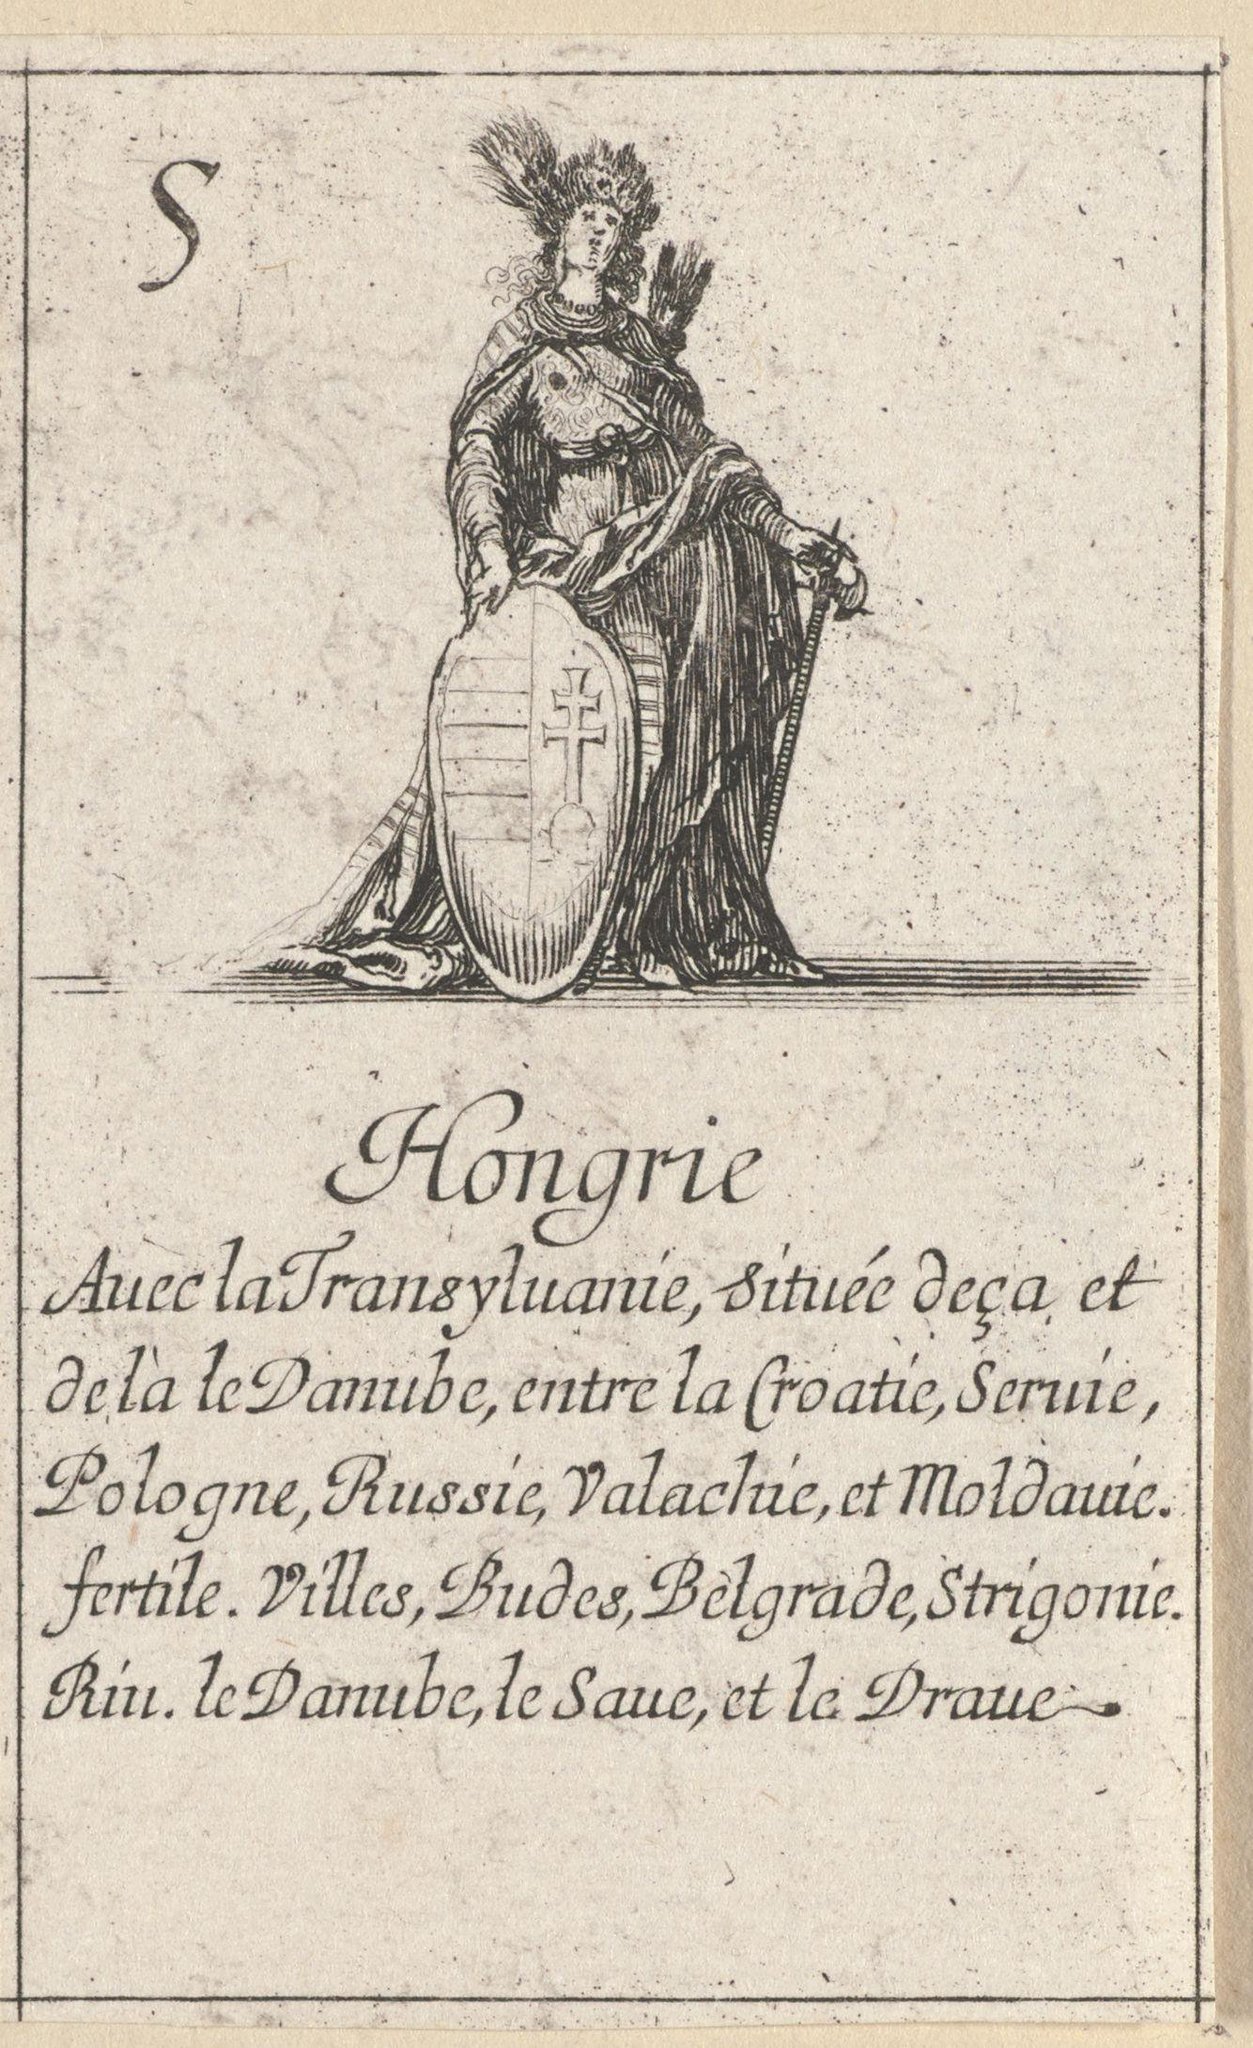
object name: print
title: Kaartspel geografie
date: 1620-1664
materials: paper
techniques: etching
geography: paris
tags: europeans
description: Deze prent maakt deel uit van een kaartspel met 52 kaarten met voorstellingen van vrouwen uit landen over de hele wereld. De serie is uitgedacht door Jean Desmarests de Saint-Sorlin in opdracht van Kardinaal Mazarin. Het kaartspel werd gemaakt voor de jonge Lodewijk XIV, samen met het Jeu des Fables, Jeu des Reynes Renommées en Jeu des Rois de France.